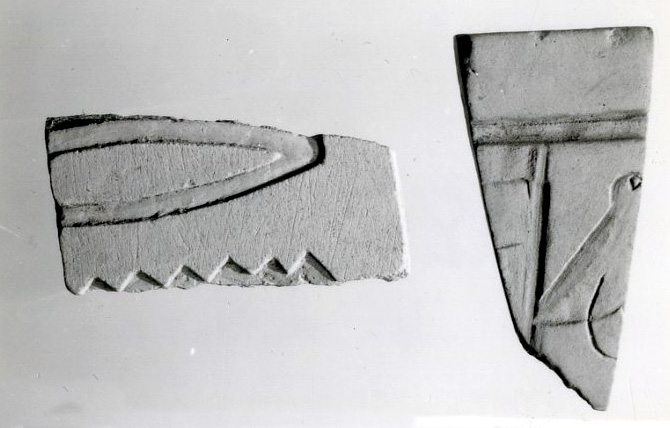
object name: relief fragment, tomb of meketre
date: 1981-1975 BCE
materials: limestone, paint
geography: egypt